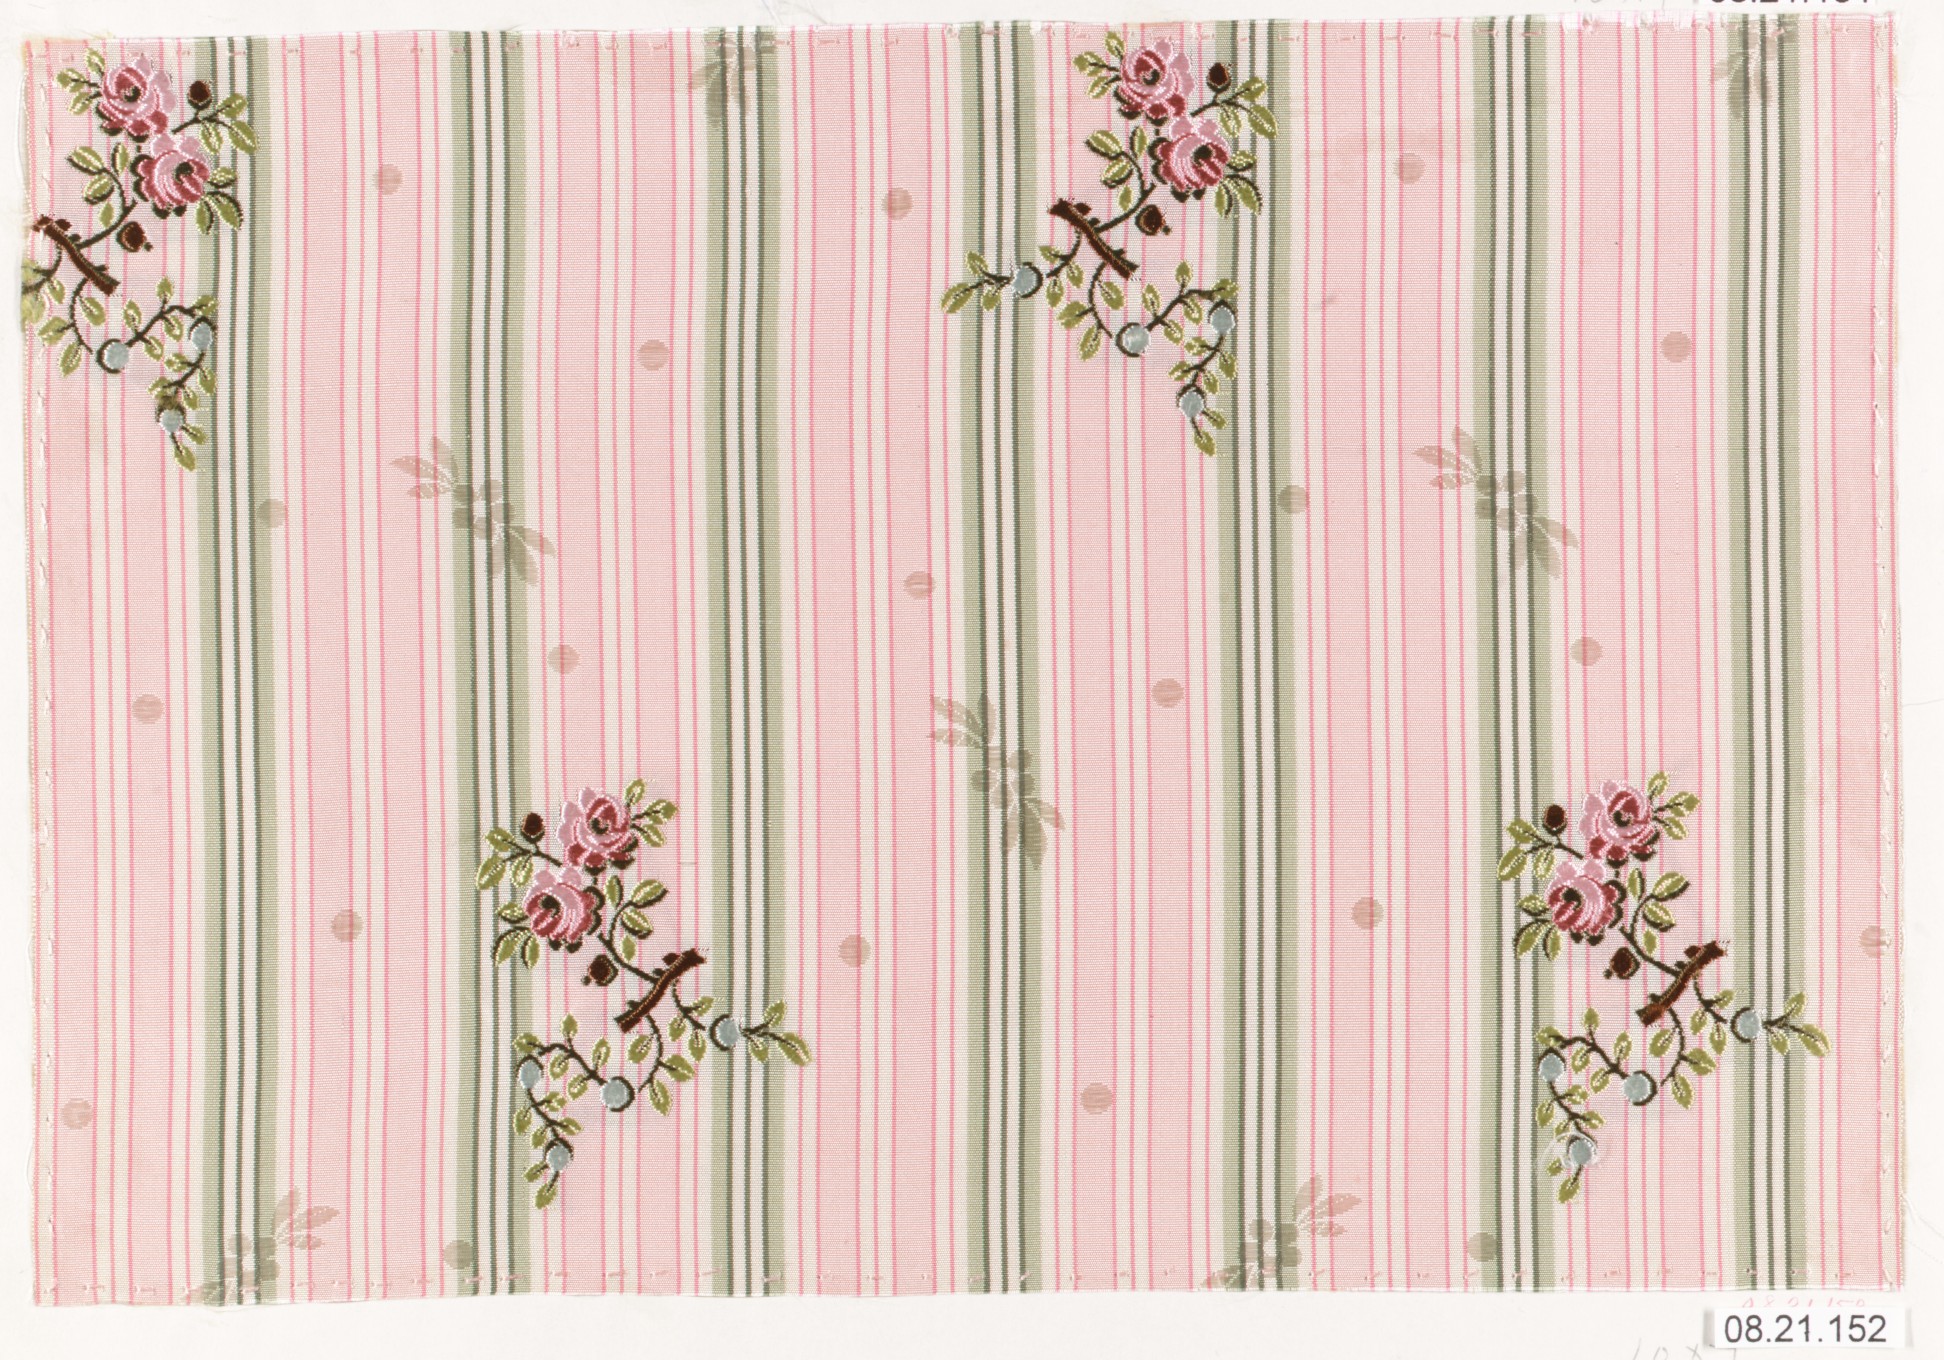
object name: textile sample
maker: Anonymous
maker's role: designer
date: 1900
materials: silk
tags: flowers